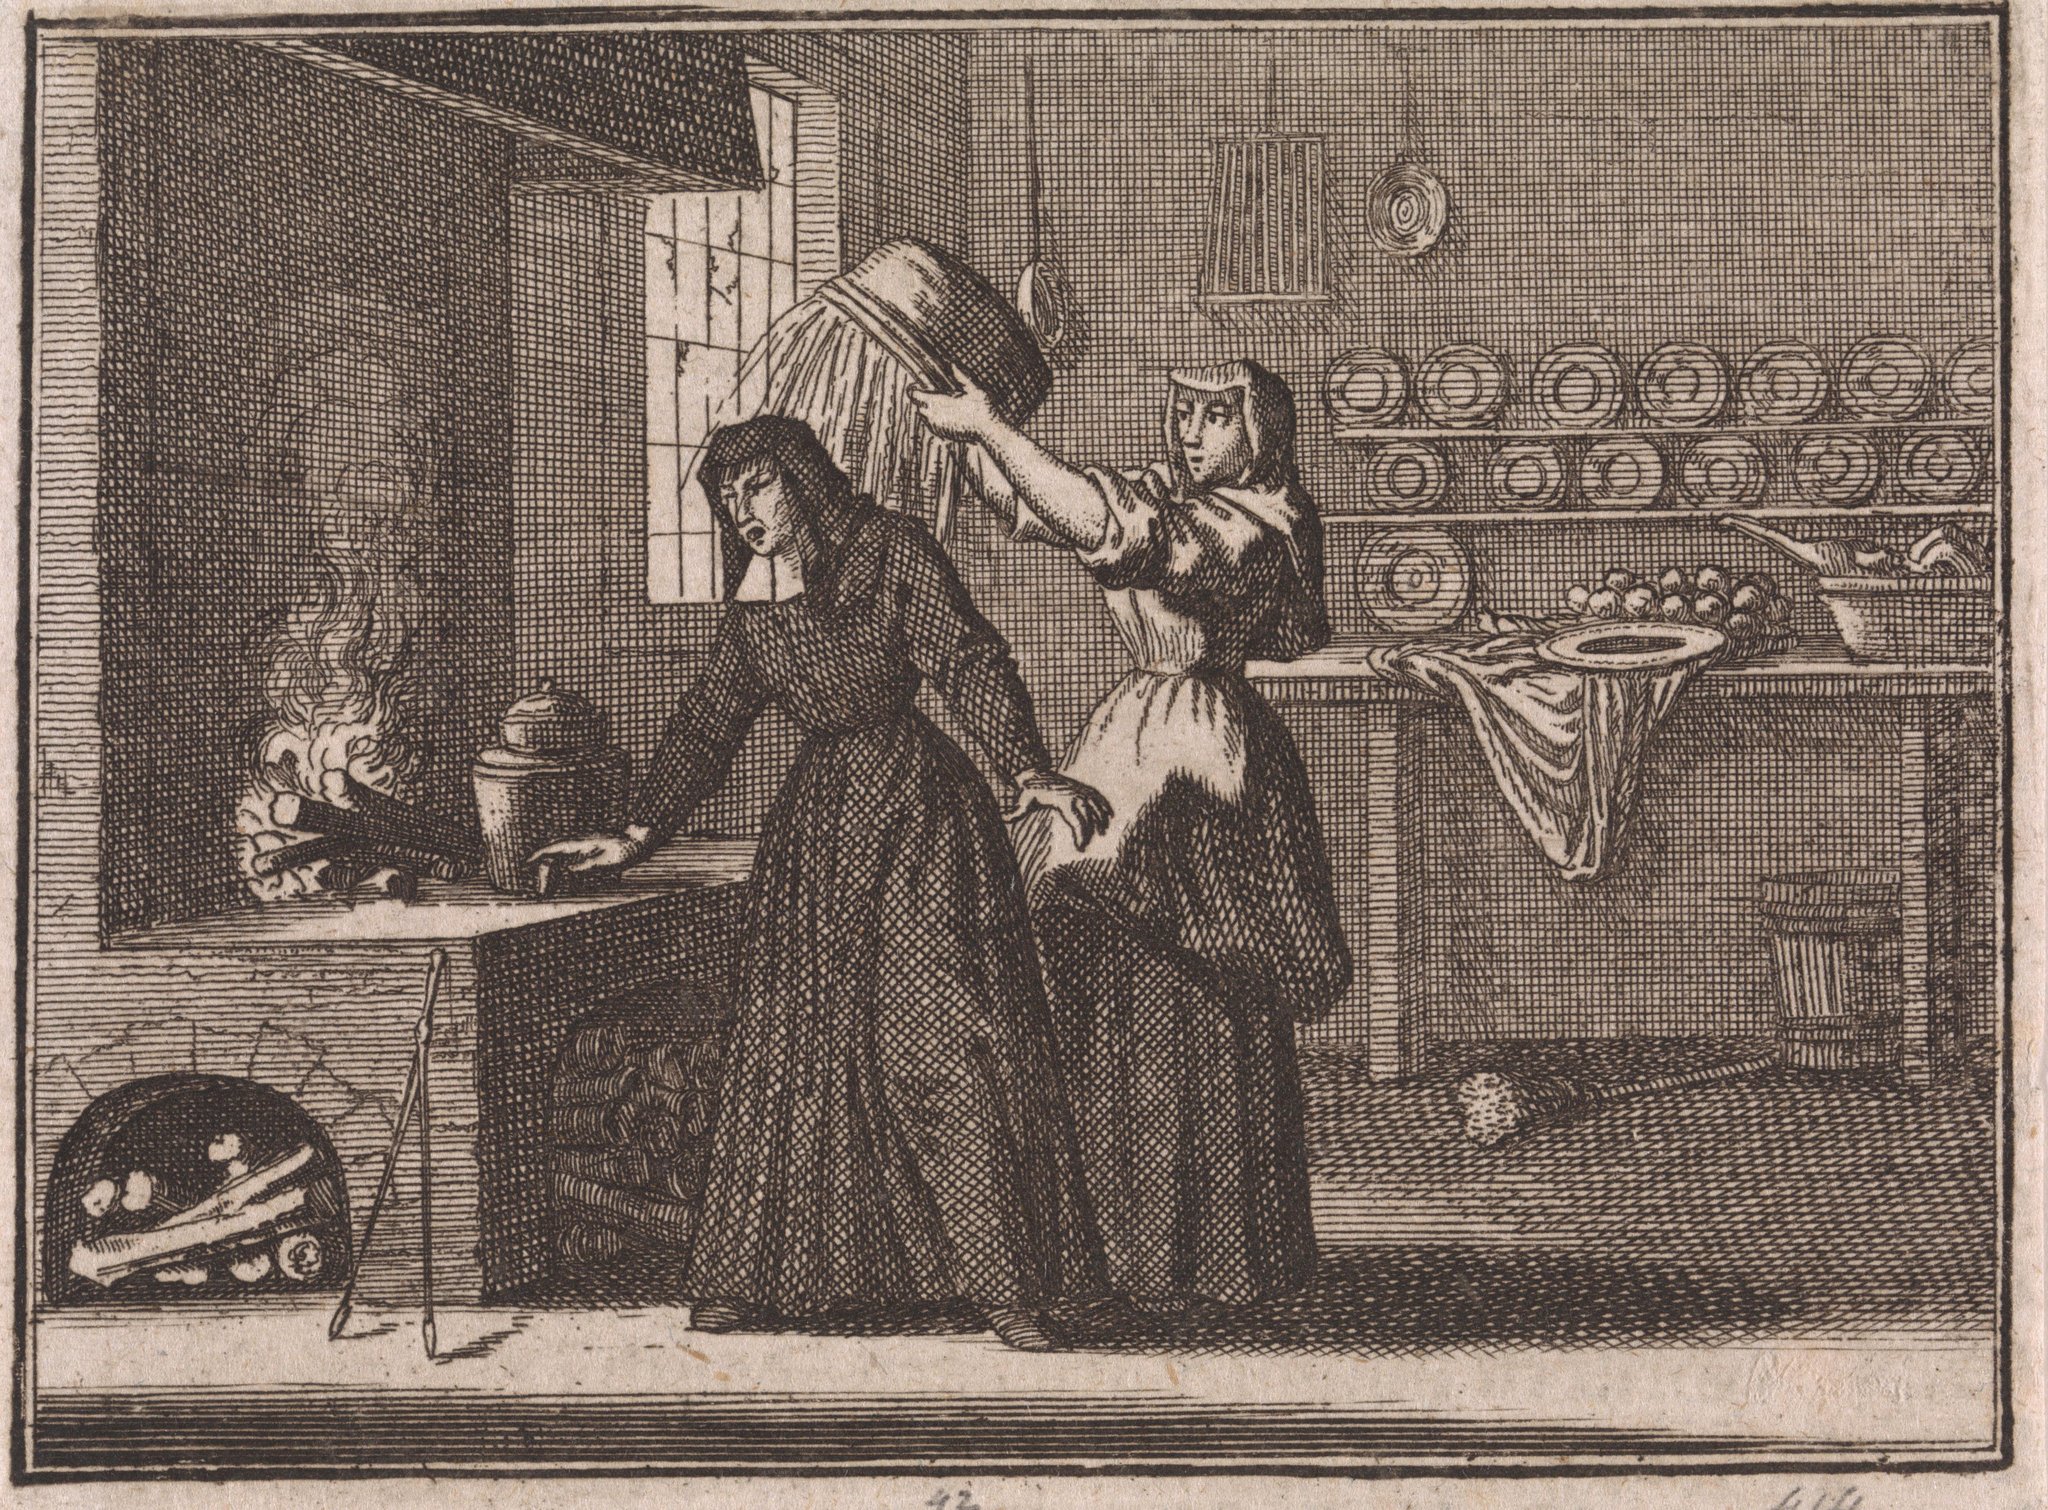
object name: book illustration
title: Dienstmeid gooit een emmer water over het hoofd van een non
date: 1704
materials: paper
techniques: etching, letterpress printing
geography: nuremberg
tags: wooden container: barrel, cask, bucket, nun(s), kitchen-maid, kitchen servant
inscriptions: collector's mark: Lugt 2228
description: Illustratie uit: Abraham a Sancta Clara. Heilsames Gemisch Gemasch, das ist: Allerley seltsame und verwunderliche Geschichten (...). Neurenberg: Christoph Weigel, 1704, p. 414.